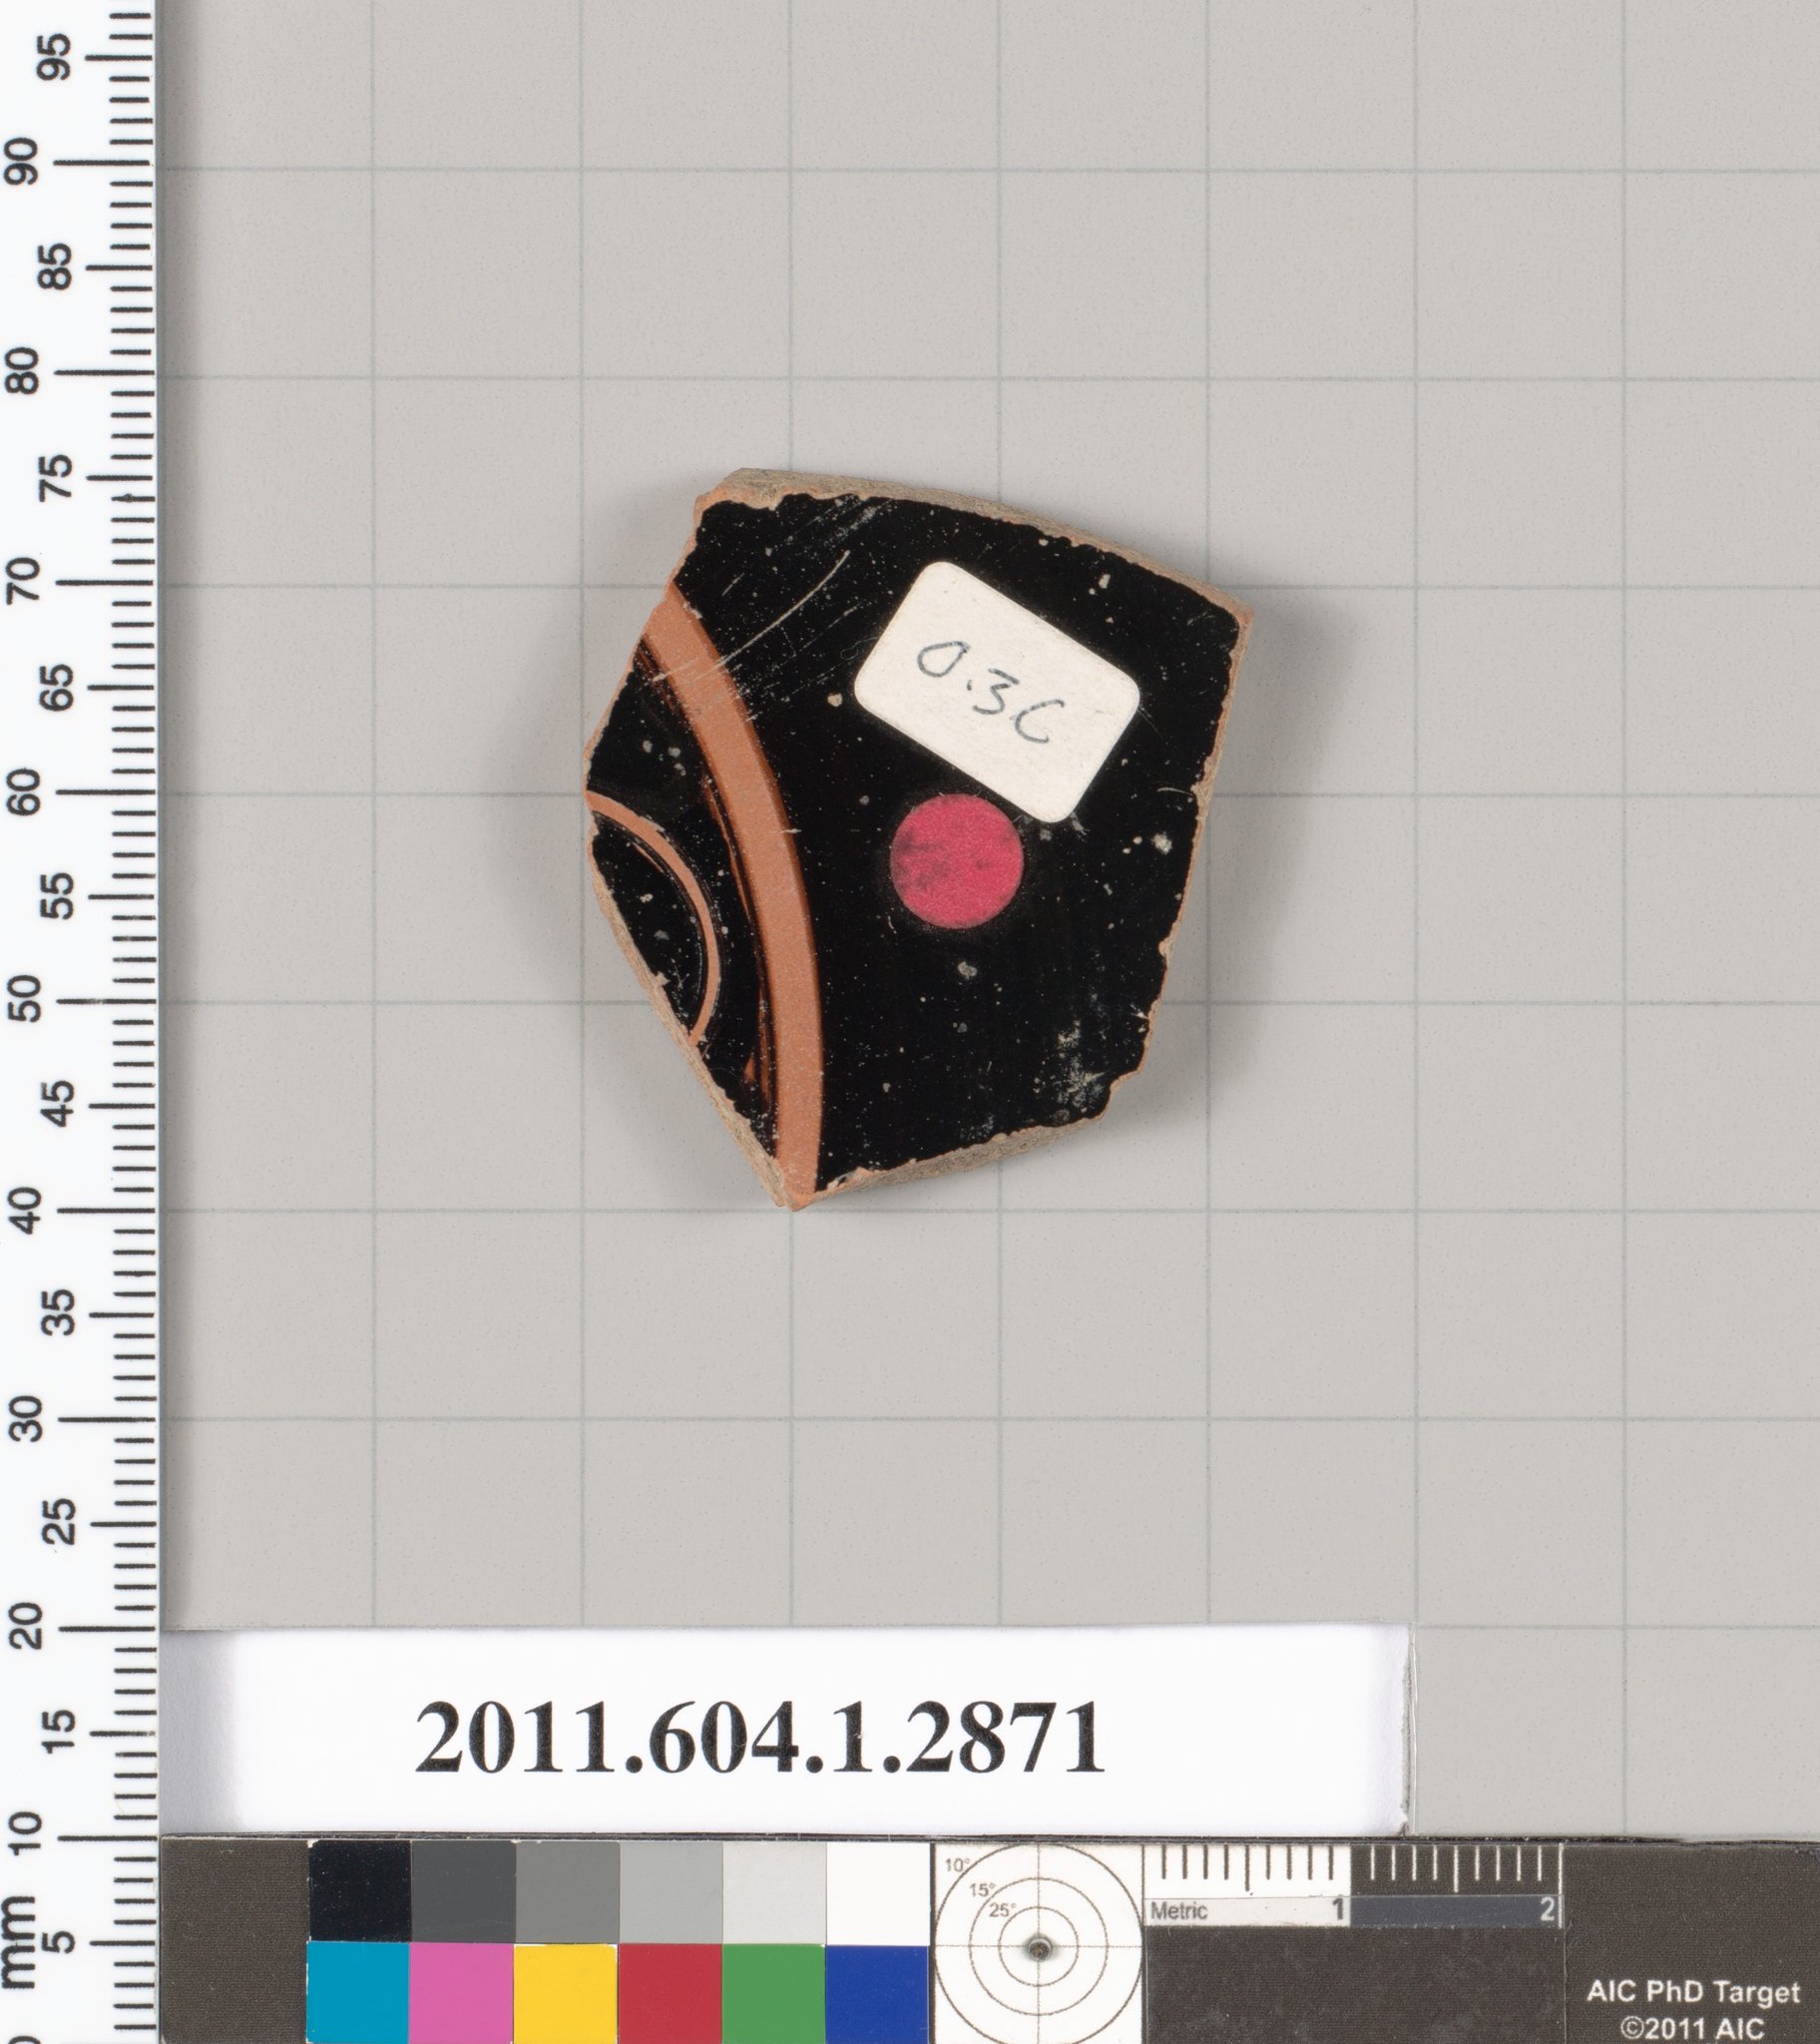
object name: kylix fragment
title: Terracotta fragment of a kylix (drinking cup)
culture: greek, attic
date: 520-490 BCE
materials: terracotta